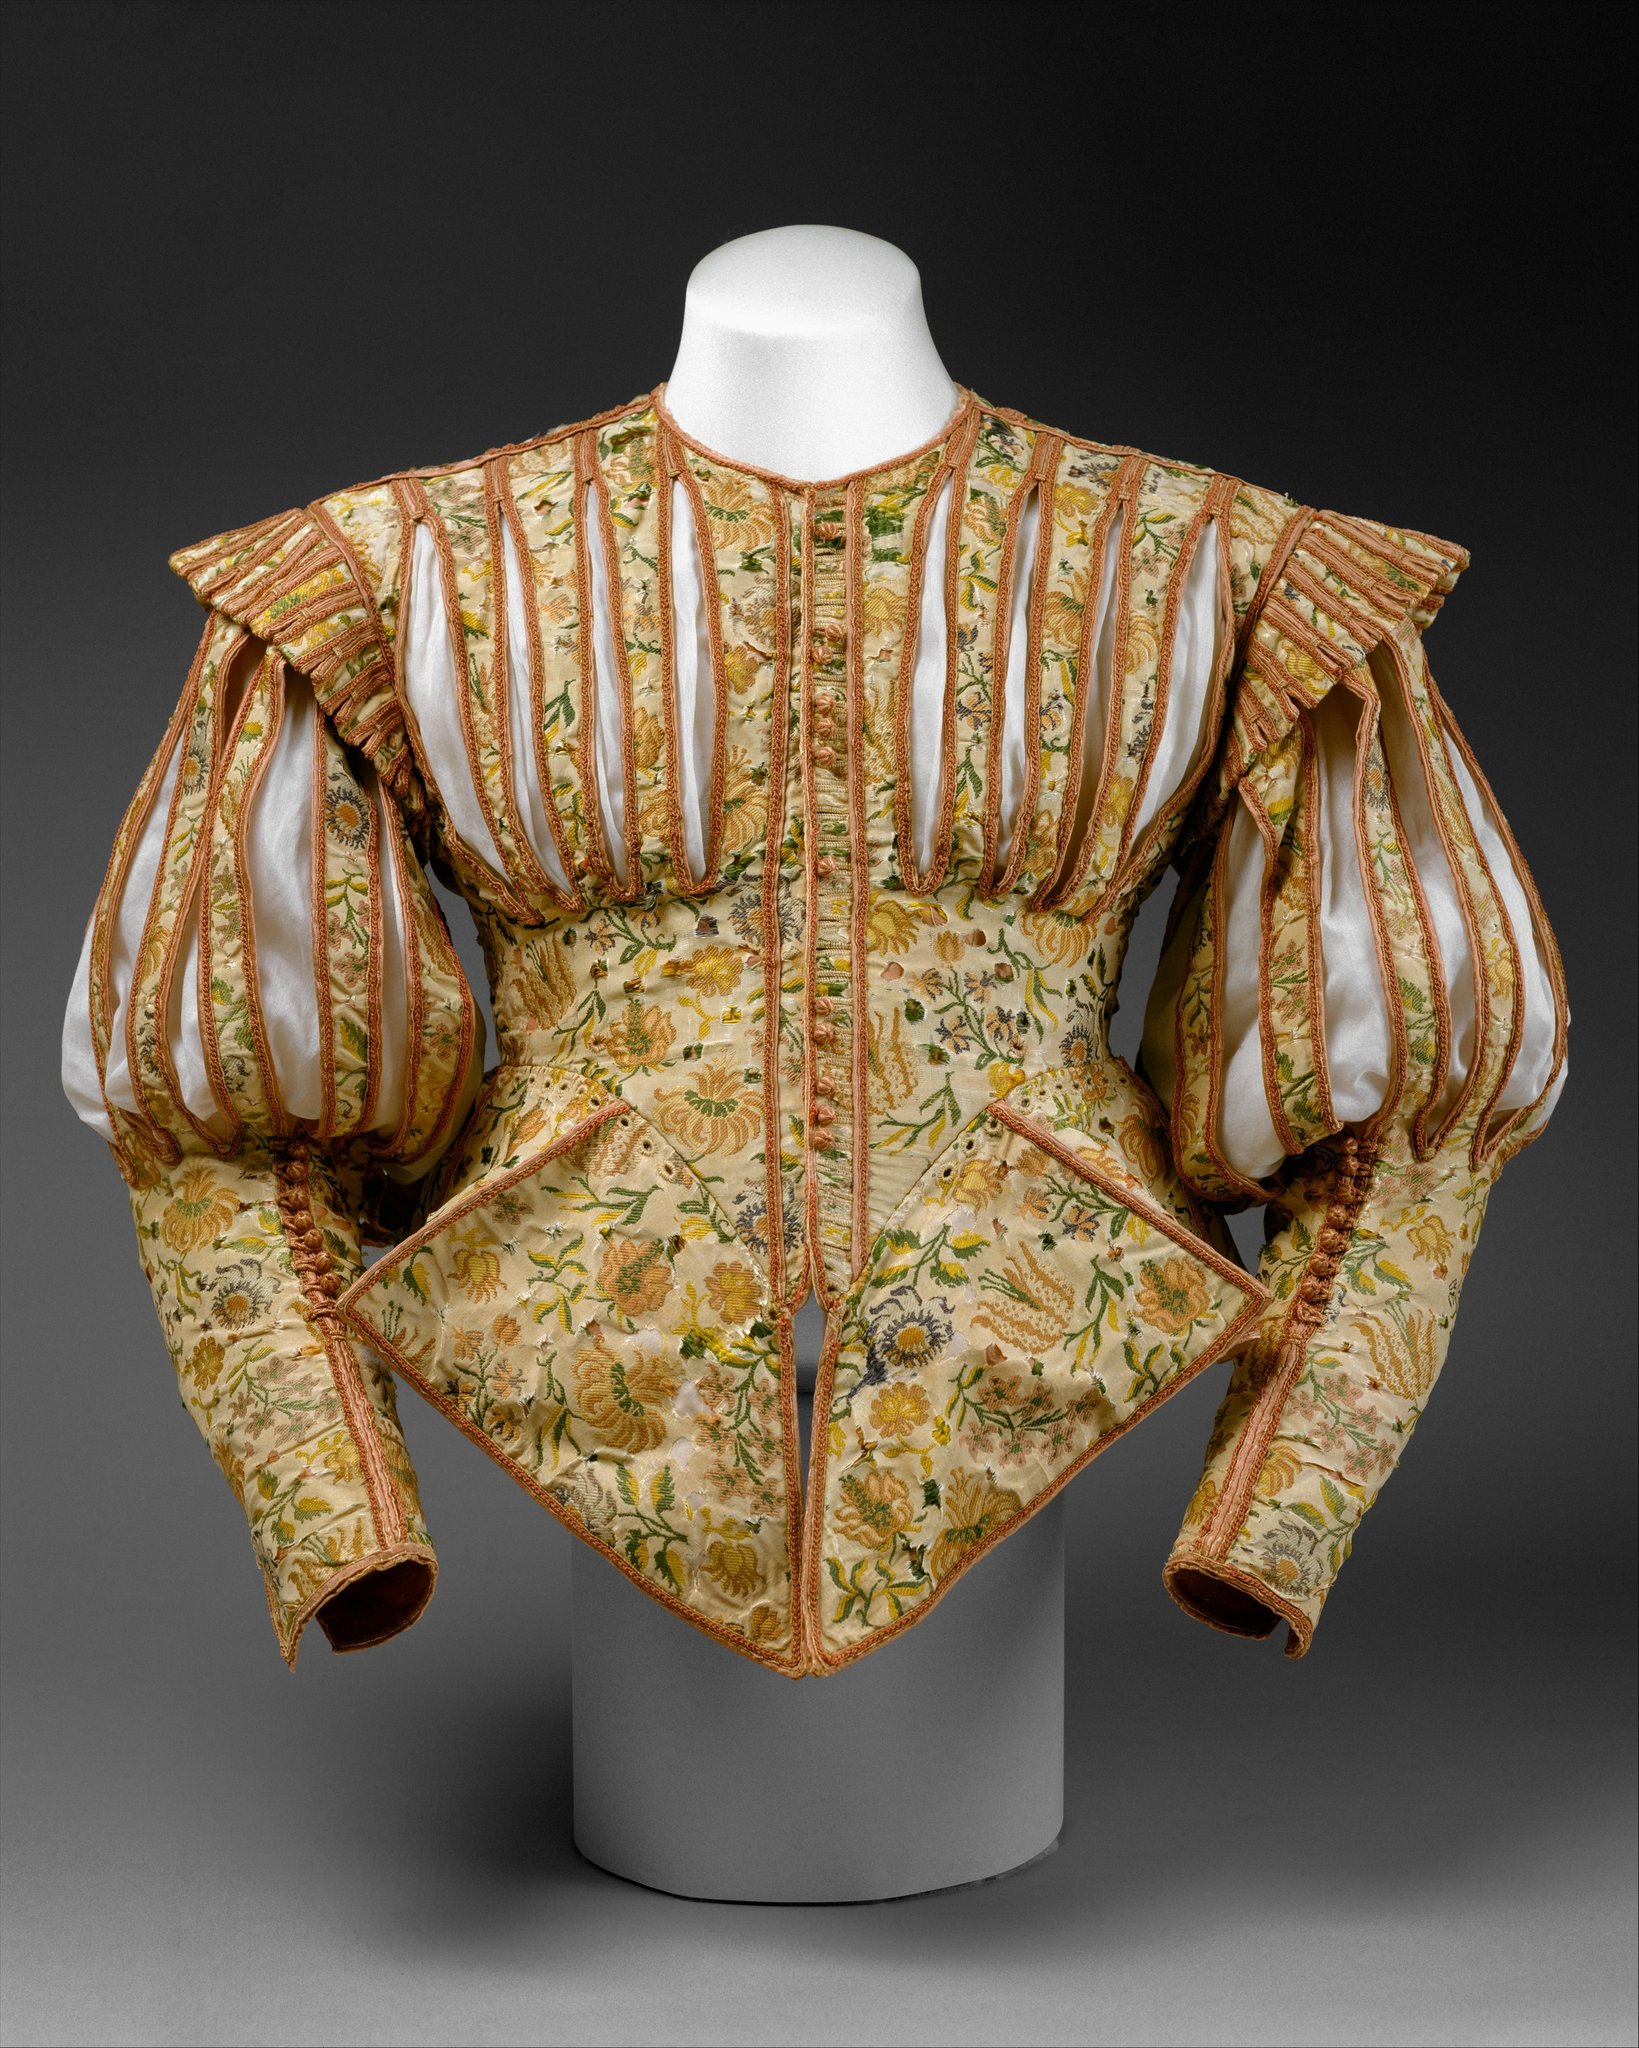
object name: doublet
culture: french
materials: silk